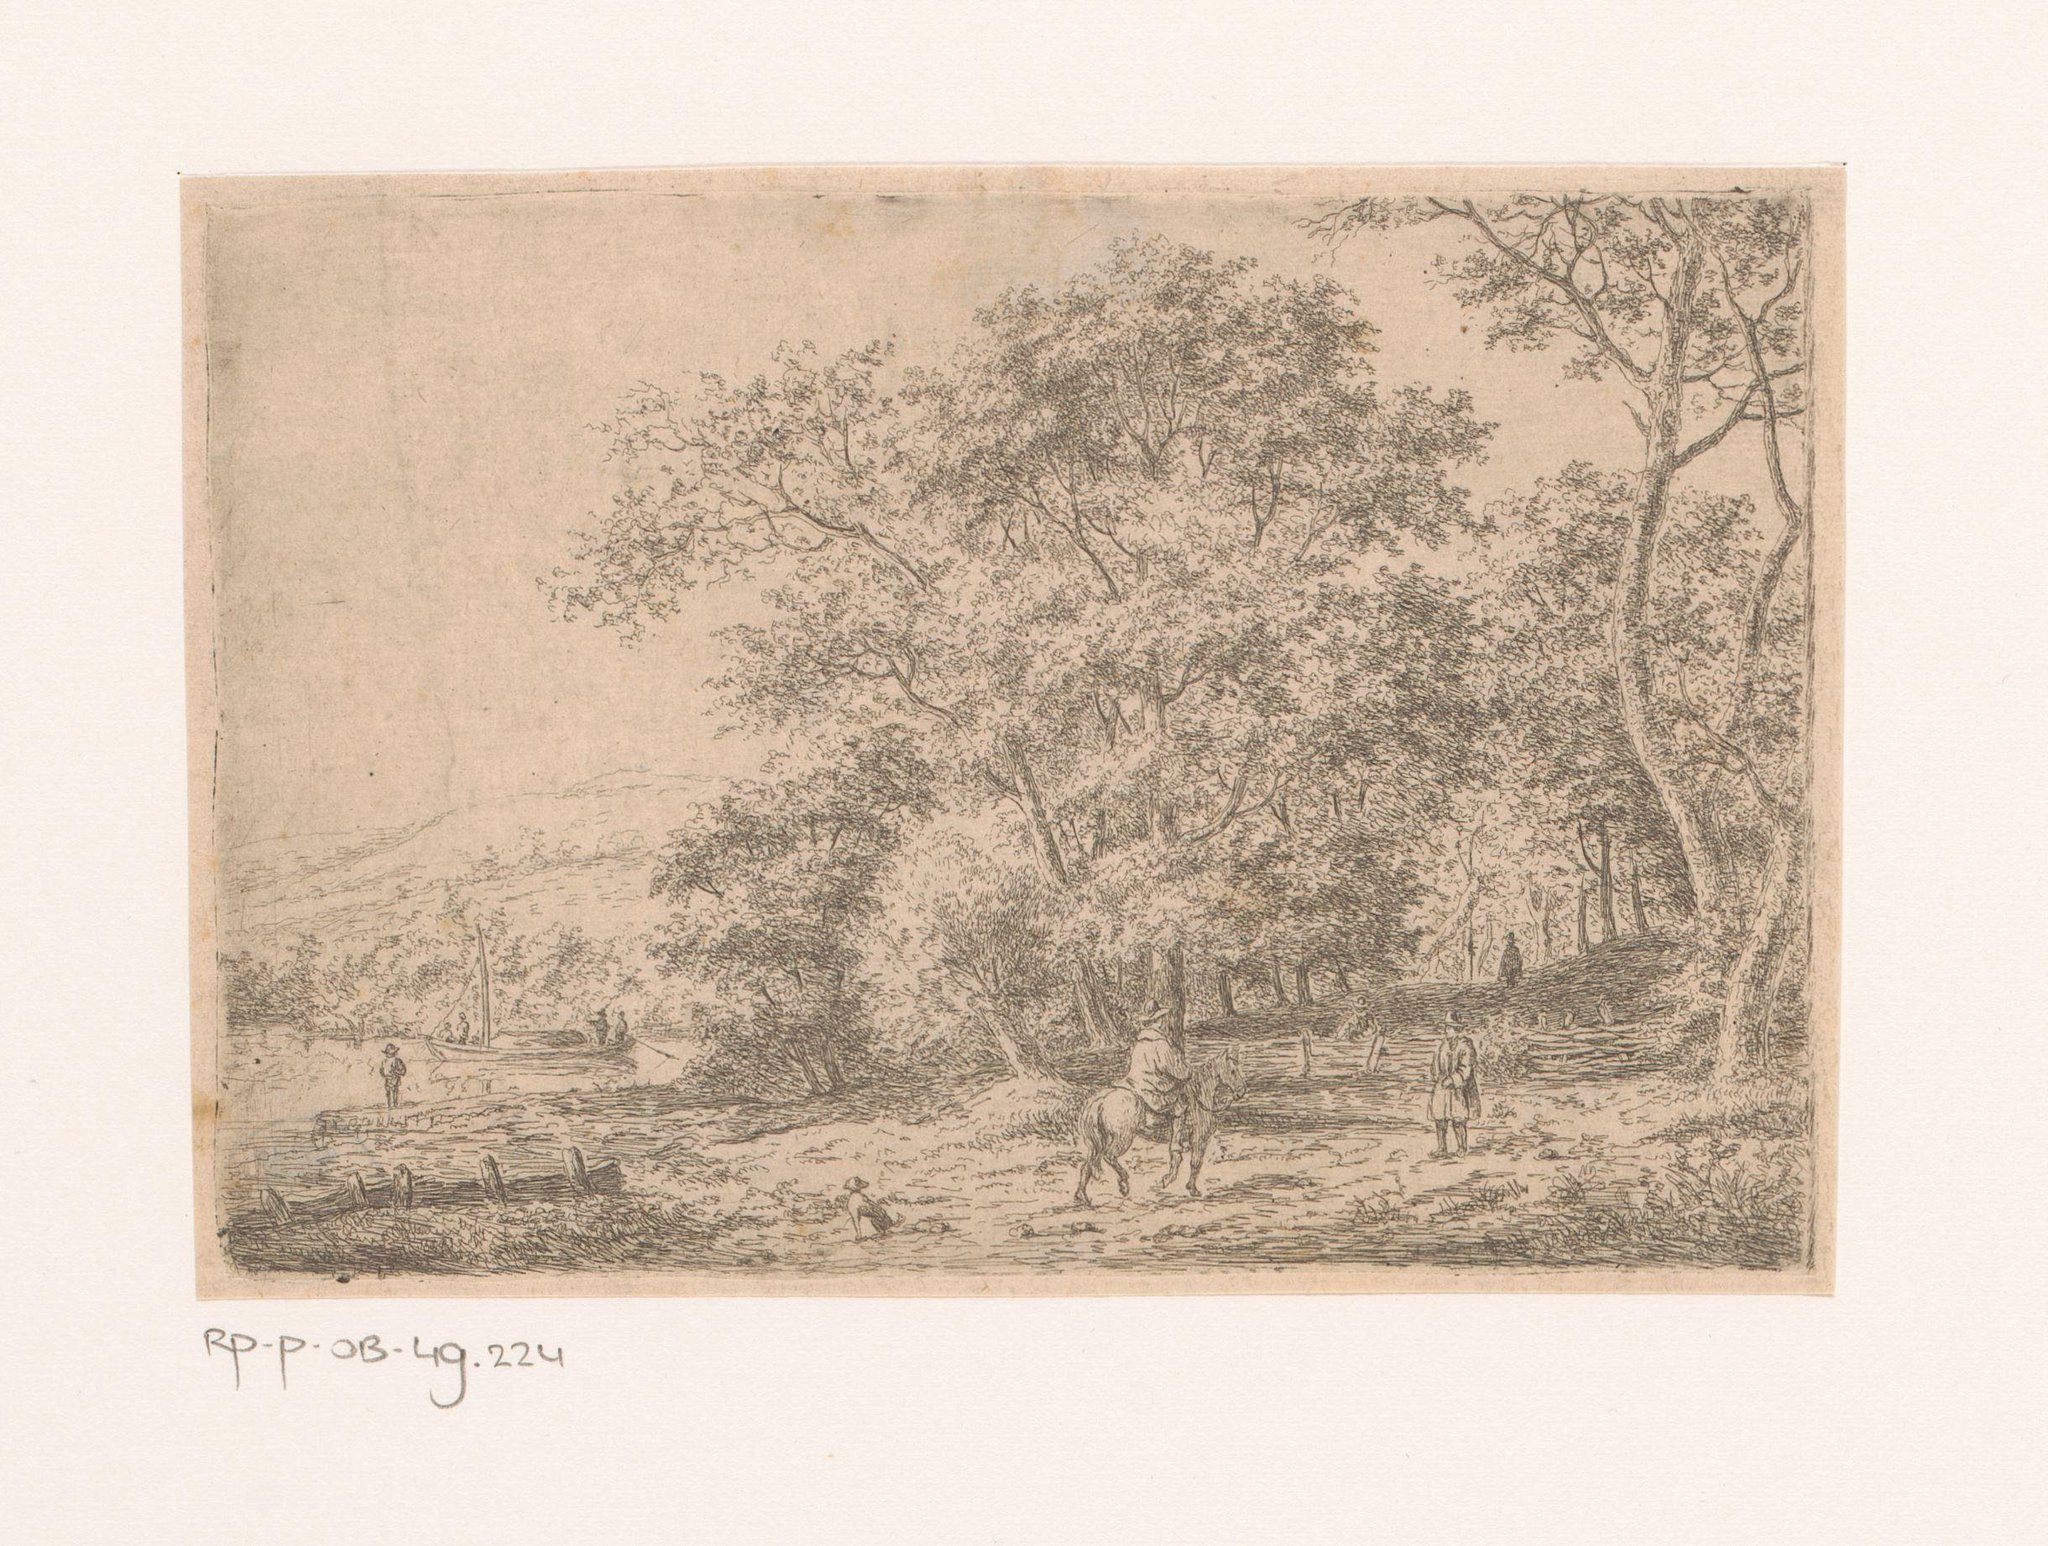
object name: print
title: Boslandschap aan een rivier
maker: jean théodore joseph linnig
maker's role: draughtsman, print maker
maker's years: 1815-1891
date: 1847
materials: paper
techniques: etching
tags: river, forest path or lane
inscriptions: collector's mark: Lugt 2227, collector's mark: Lugt 514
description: Voor de ontwerptekening van deze prent, zie RP-T-1912-8.